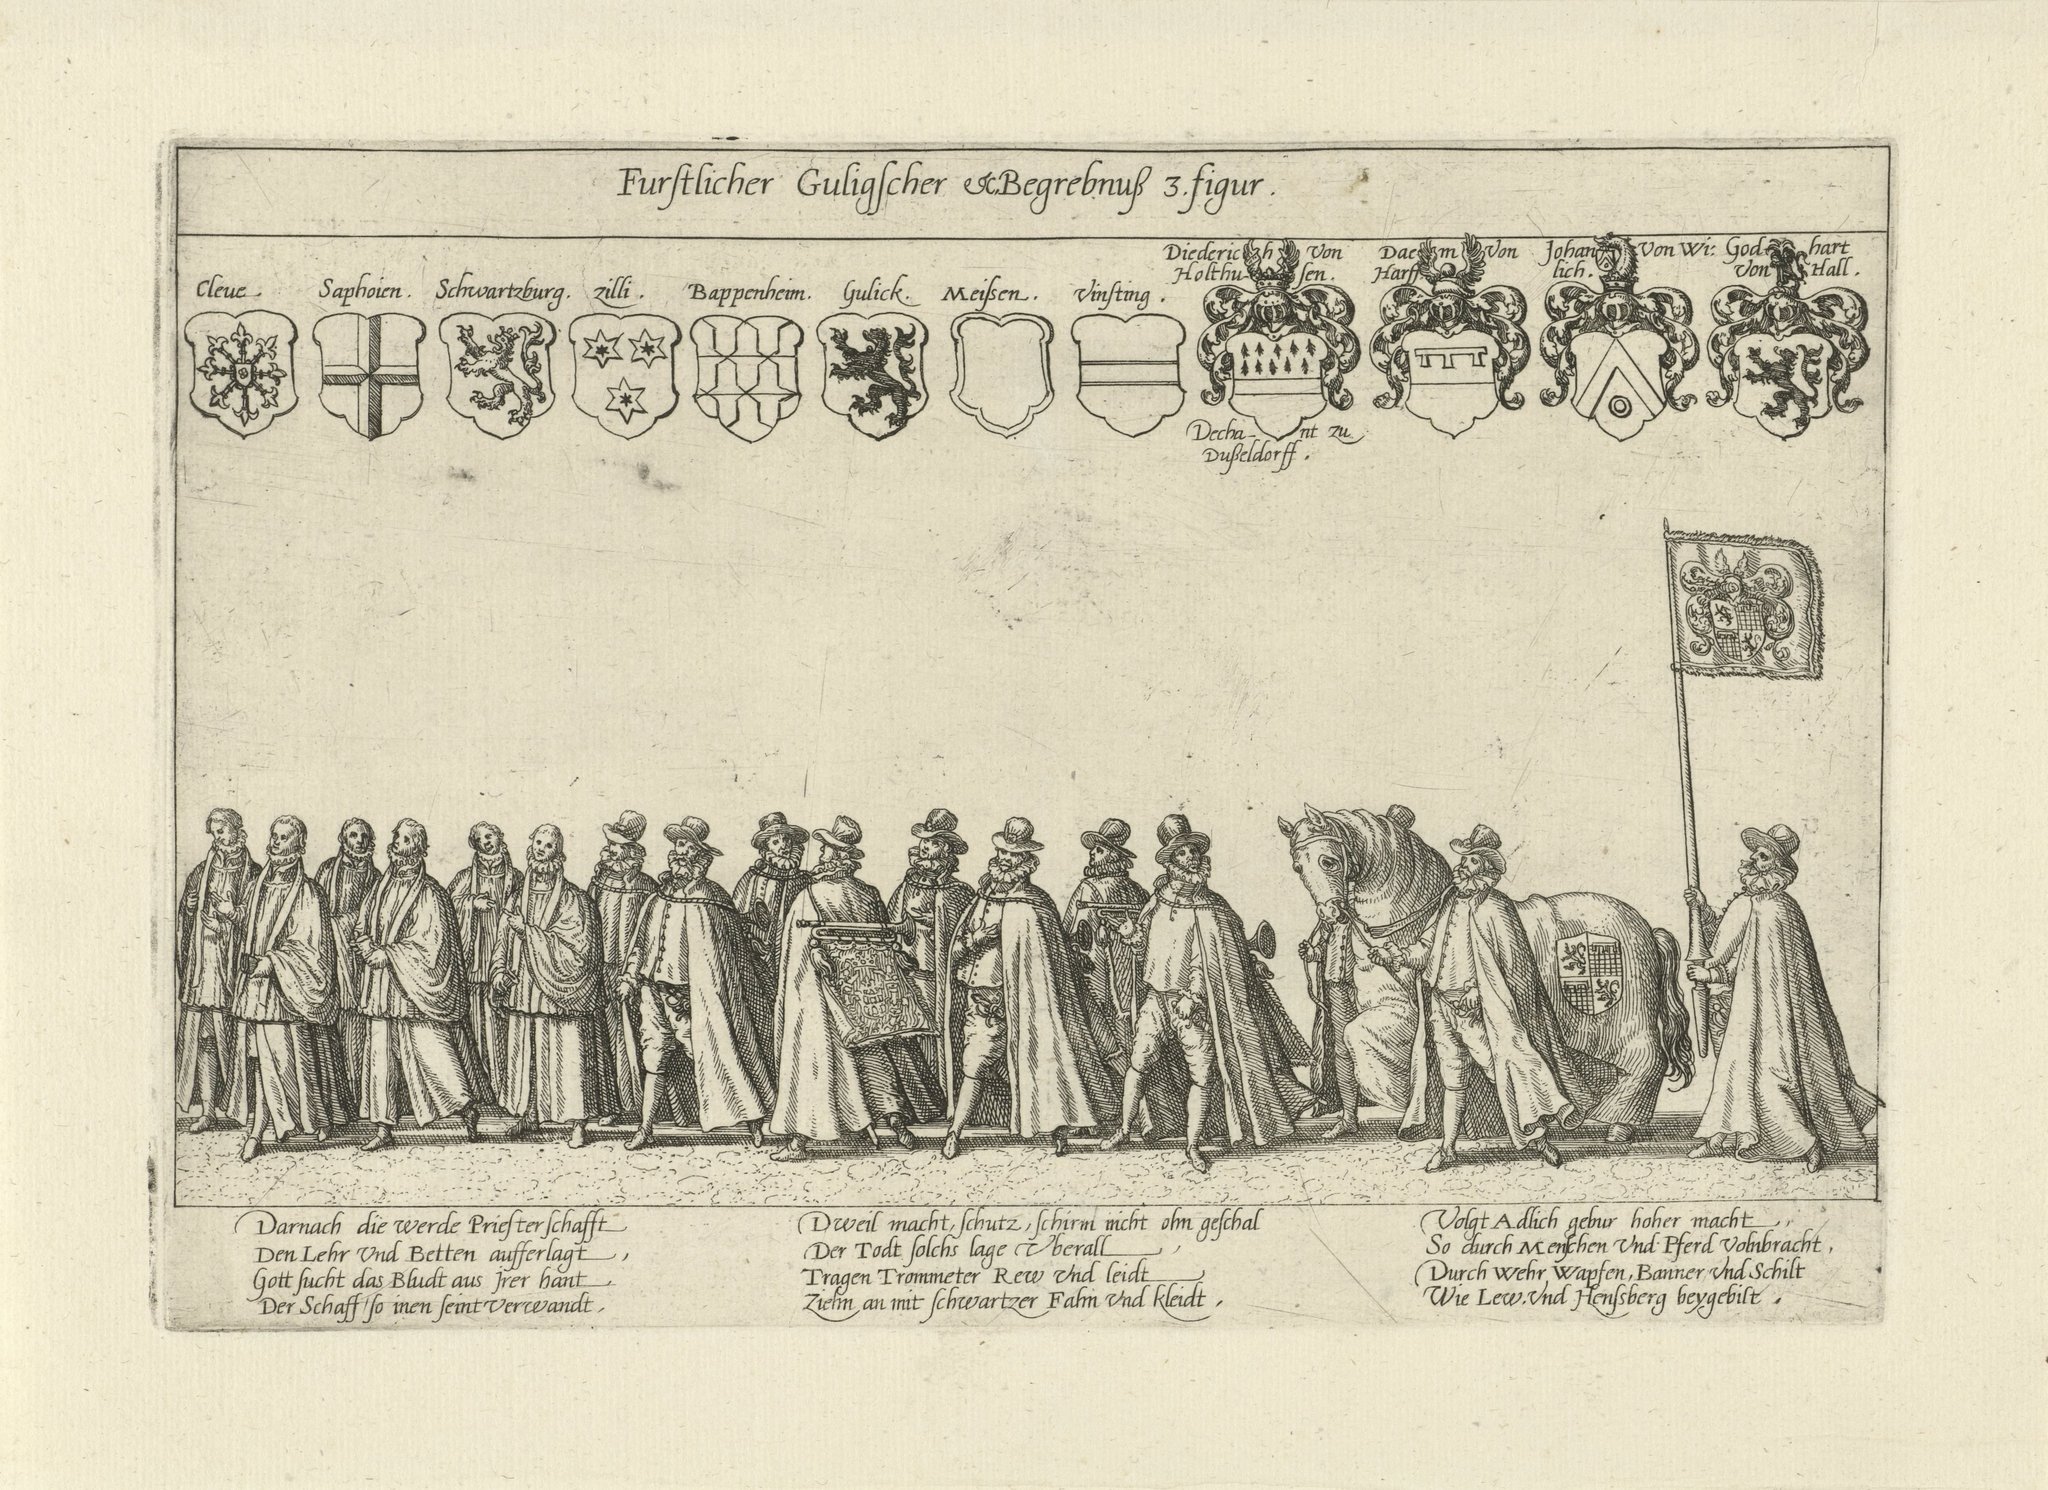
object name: print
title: Begrafenisstoet met geleerden en edelen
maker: Anonymous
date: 1592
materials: paper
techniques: etching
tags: funerary ceremonial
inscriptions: collector's mark: Lugt 2228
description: Prent ook gebruikt in: Graminaeus, Theodor. Spiegel vnd abbildung der Vergengligkeit: Darinnen was der Toden Recht vnd Geburnuß begriffen ... Vnd wie der Durchleuchtiger ... Herr Johan Wilhelm Hertzog zu Gülich, Cleue vnd Berg ... da jhr F.G. Herr Vatter Christmilter gedechtnuß, Hertzog Wilhelm ... im Jahr 1592. ... entschlaffen, ... am zehenden Tag Martij in der Collegiat Kirchen zu Düsseldorff ... begraben ... lassen. Keulen: Theodor Graminaeus, 1592.